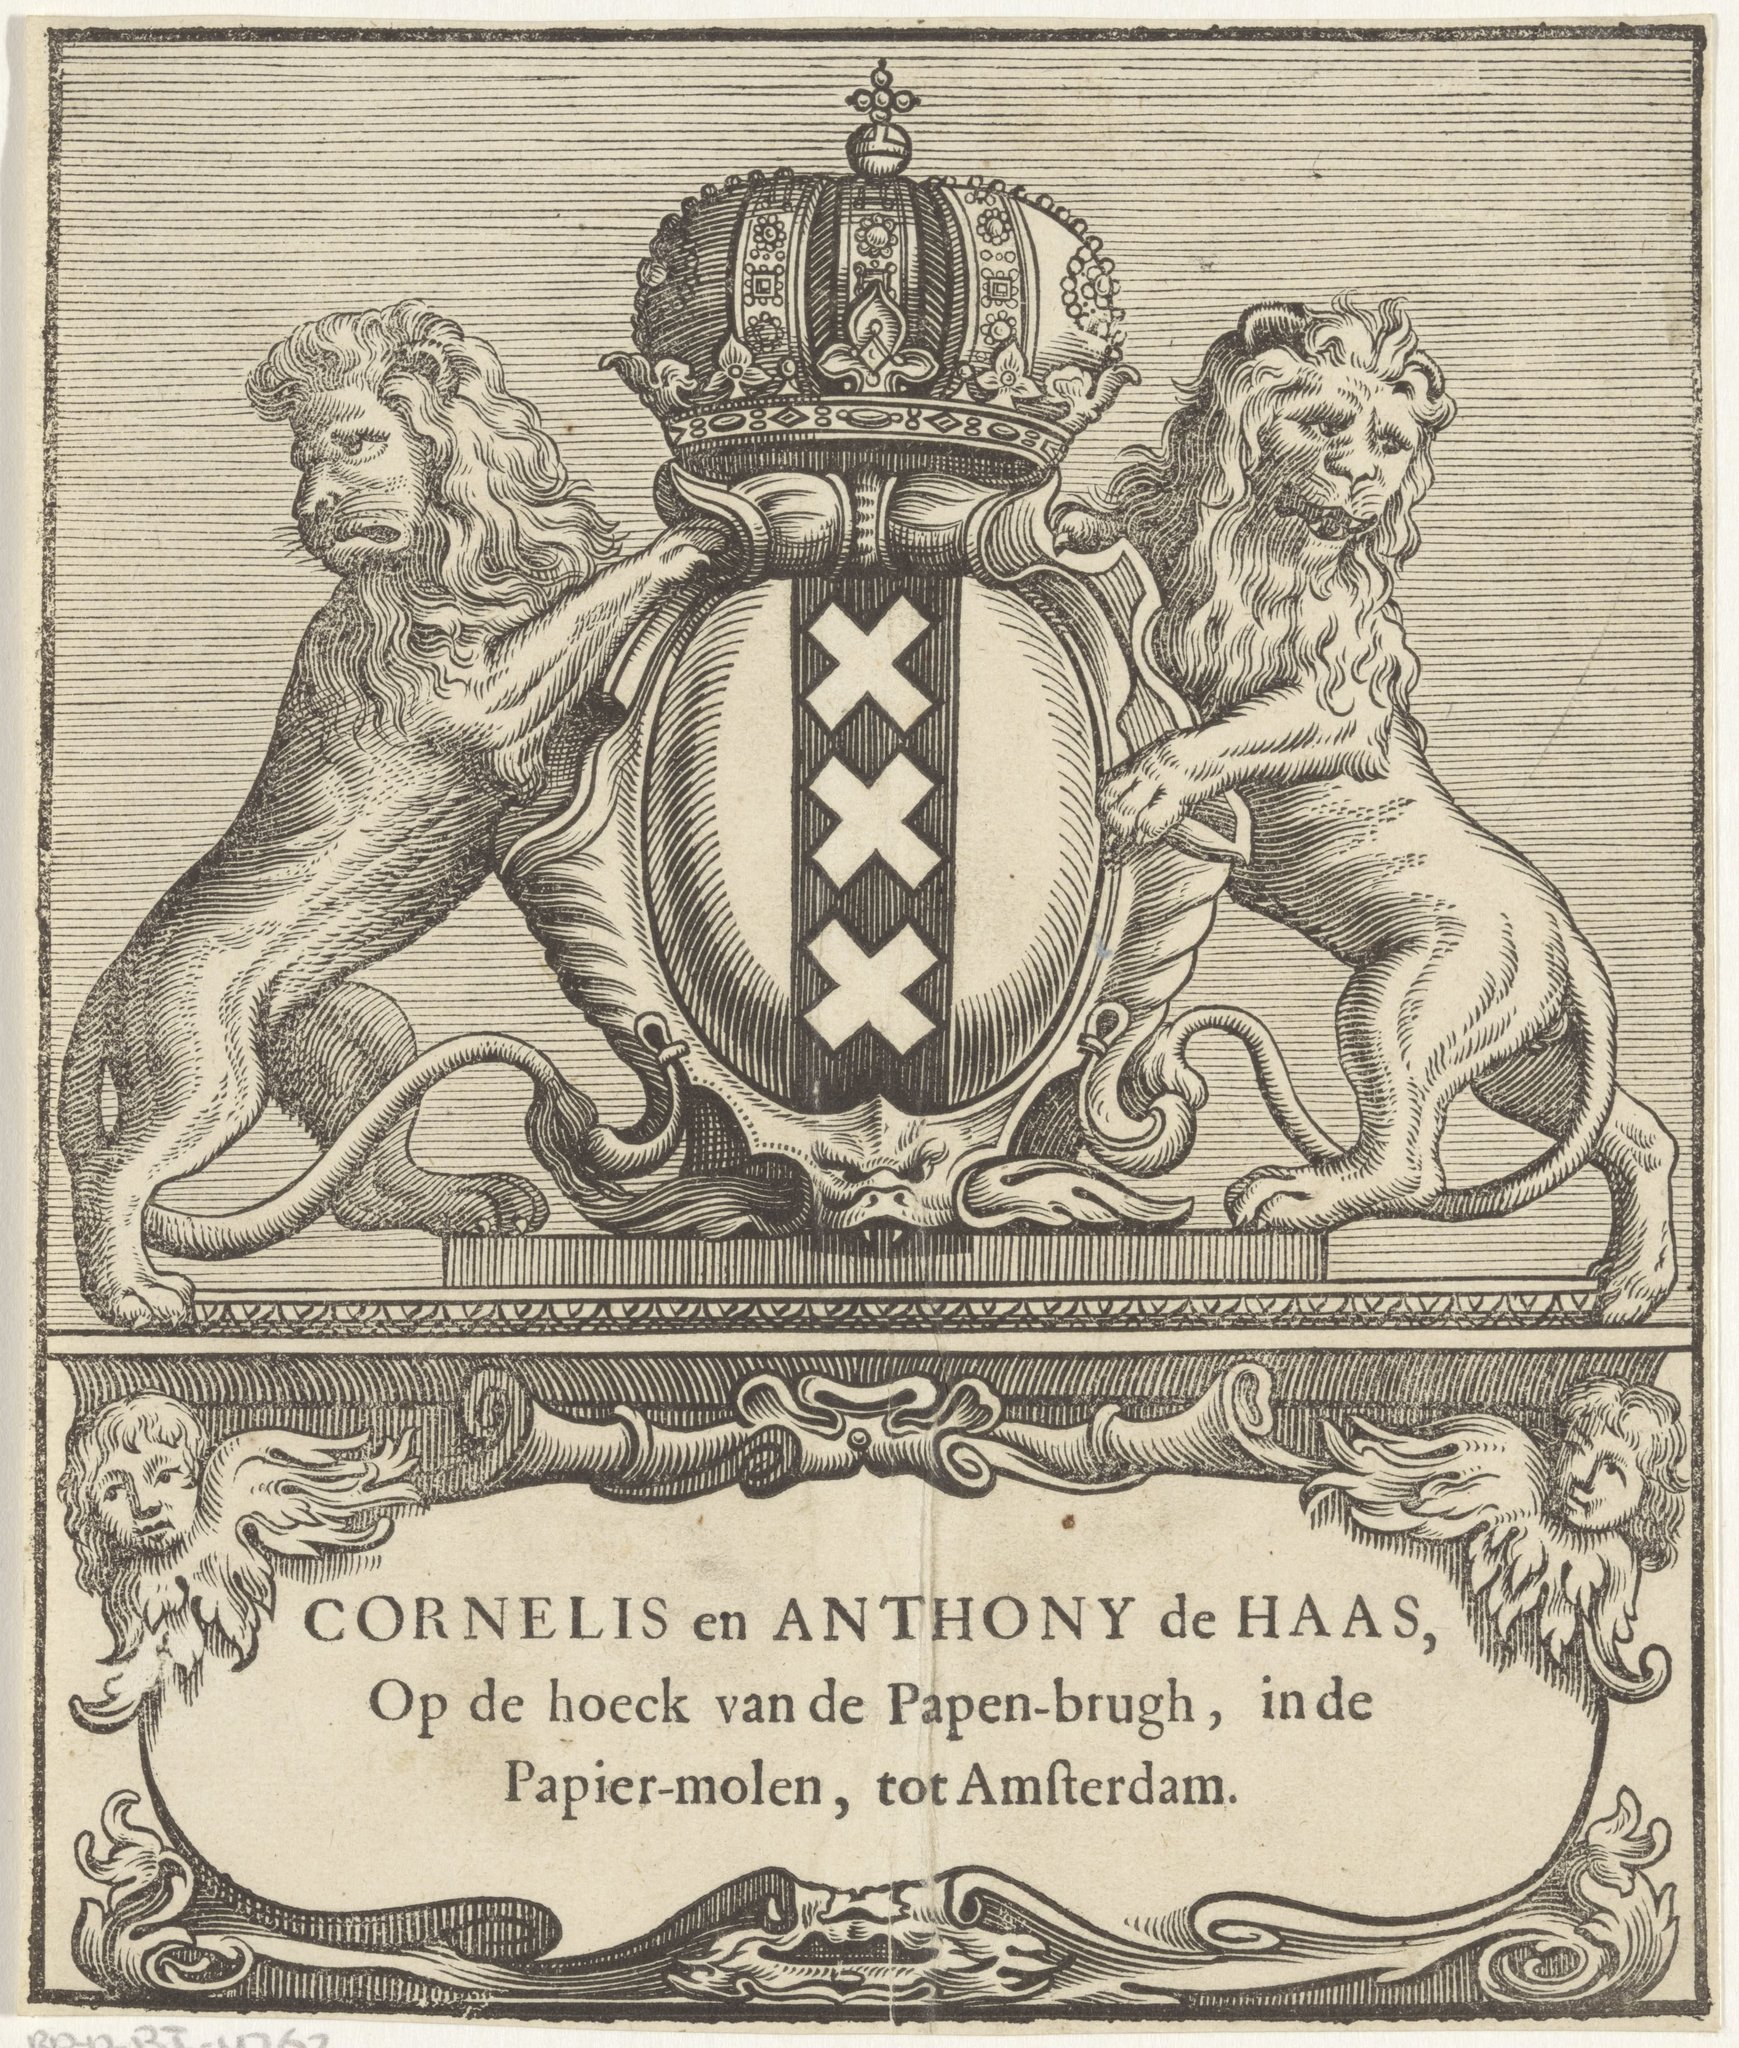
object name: print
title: Wapen van de stad Amsterdam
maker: Anonymous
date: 1600-1699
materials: paper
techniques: letterpress printing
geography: netherlands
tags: coat of arms (as symbol of the state, etc.) (+ city; municipal), amsterdam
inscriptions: collector's mark: Lugt 240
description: Het wapen van de stad Amsterdam met een kroon, twee leeuwen en drie Andreaskruisen. Daaronder een cartouche.